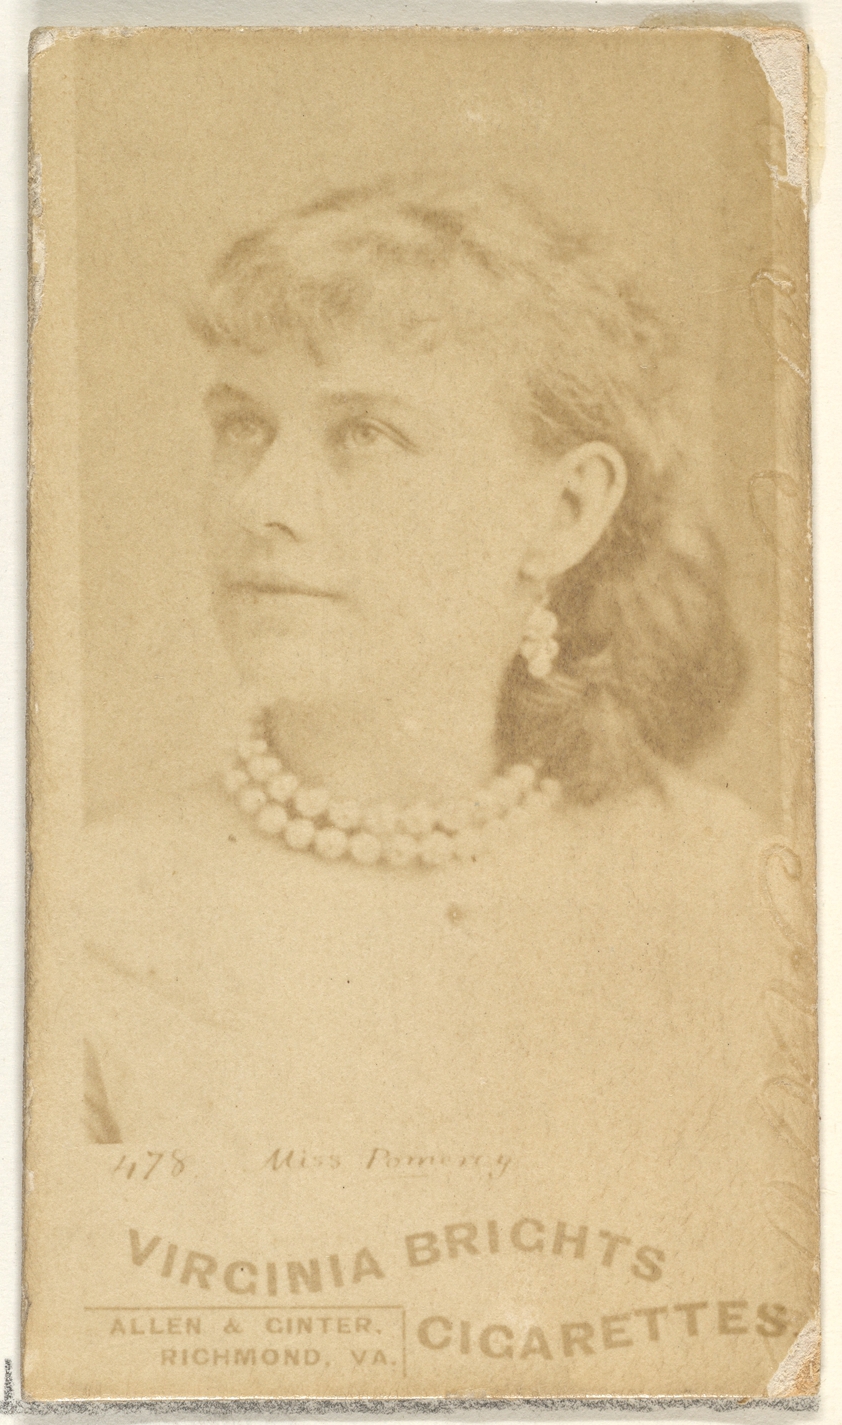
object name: photograph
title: Card 478, Miss Pomeroy, from the Actors and Actresses series (N45, Type 1) for Virginia Brights Cigarettes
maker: allen & ginter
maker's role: publisher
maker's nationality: american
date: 1888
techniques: albumen silver print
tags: portraits,women,actresses